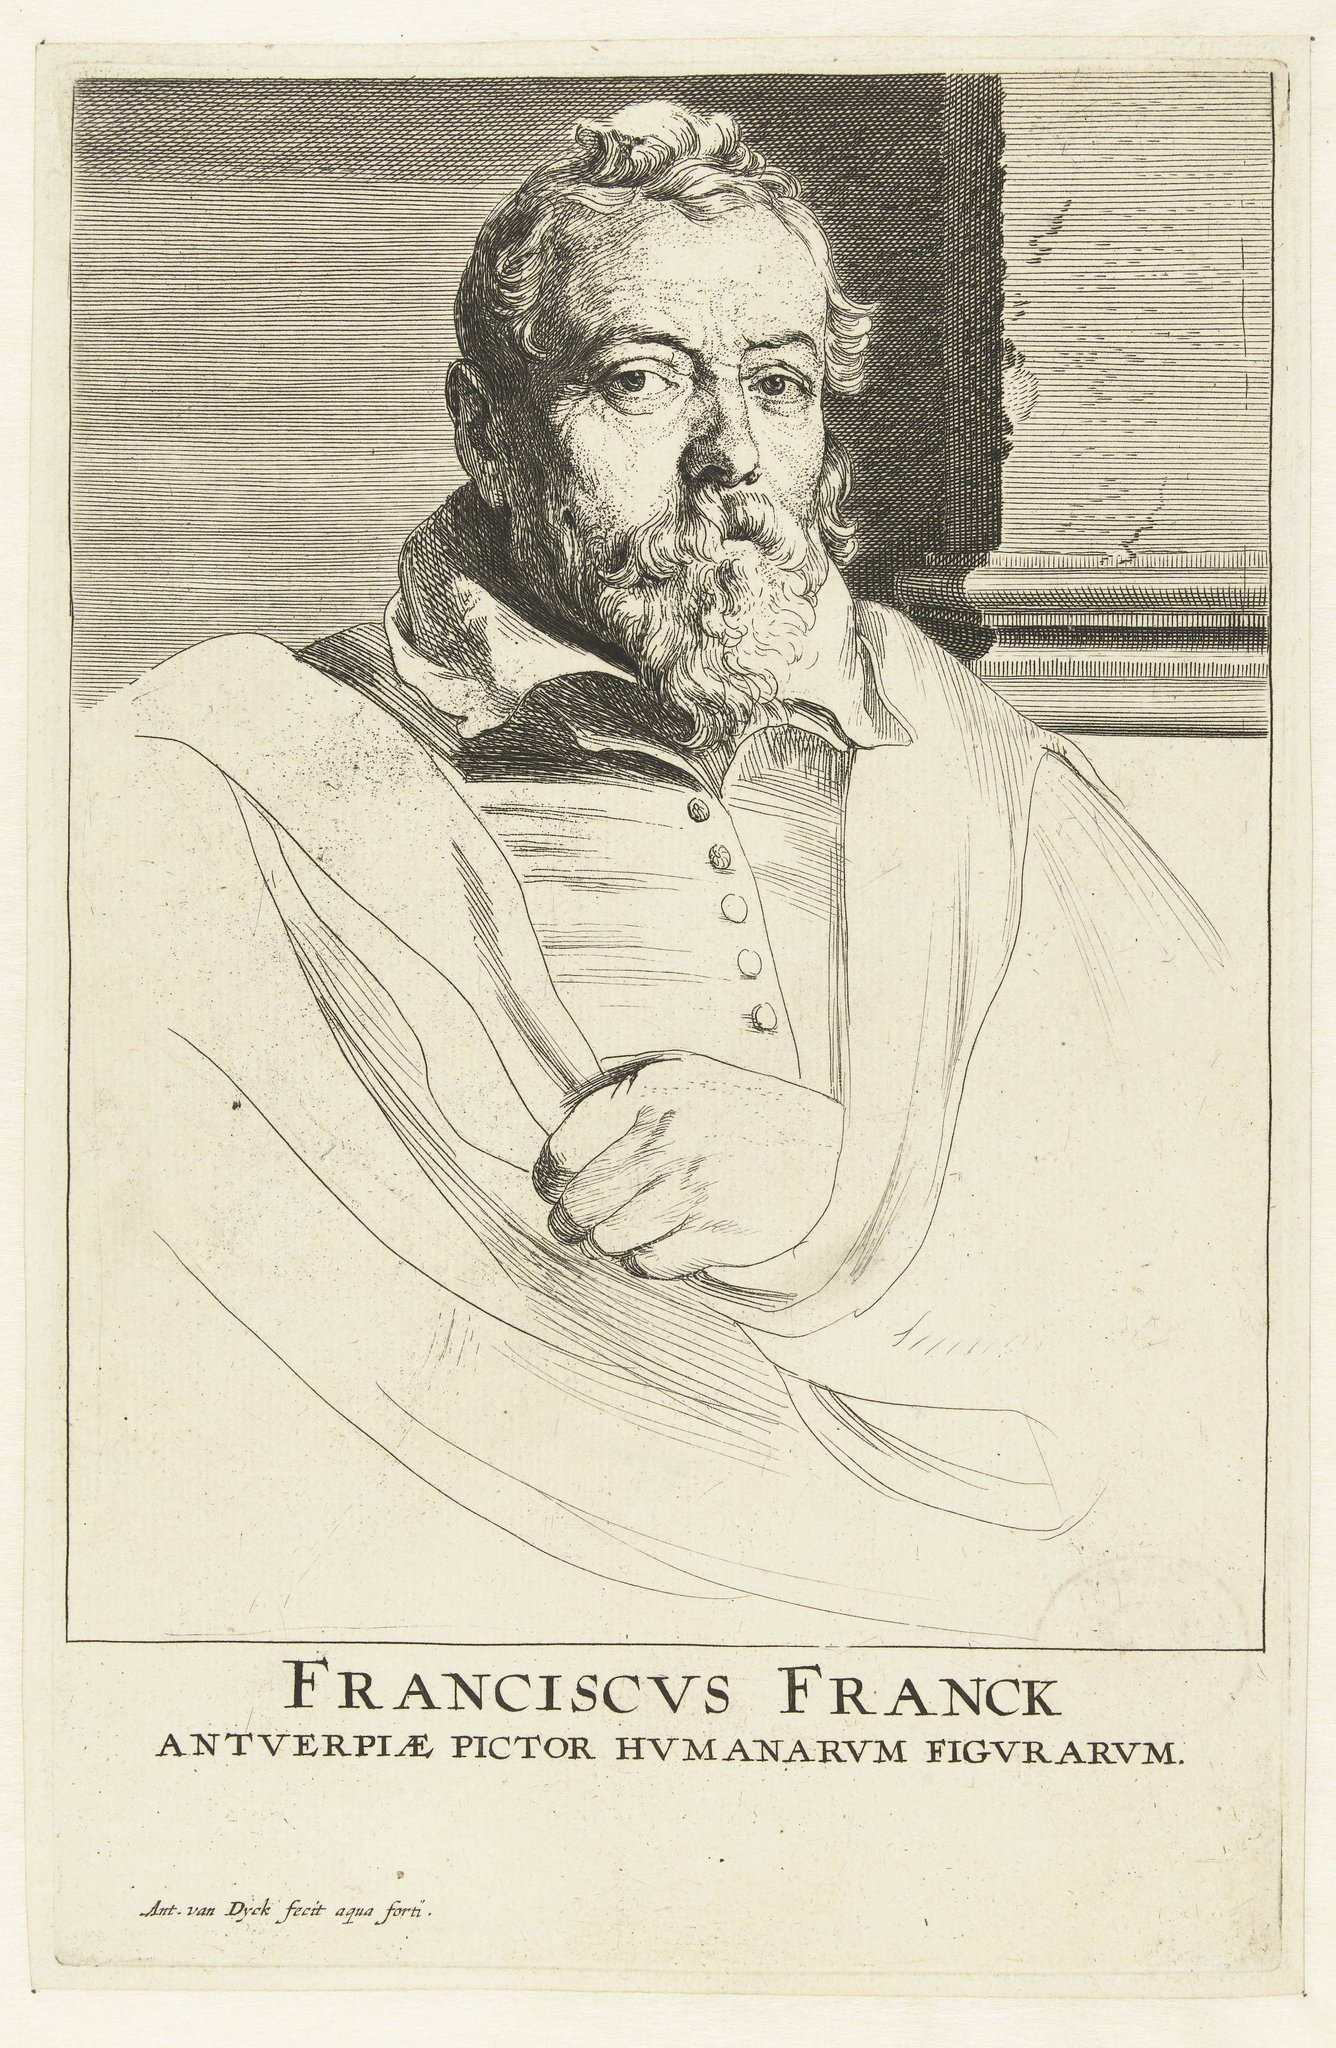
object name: print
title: Iconographie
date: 1630-1641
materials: paper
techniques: engraving, etching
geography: low countries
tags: frans francken (i), portrait, self-portrait of painter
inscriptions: collector's mark: Lugt 240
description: Portret van Frans Francken II met onderschrift FRANCISCVS FRANCK ANTVERPIAE PICTOR HVMANARVM FIGVRARVM